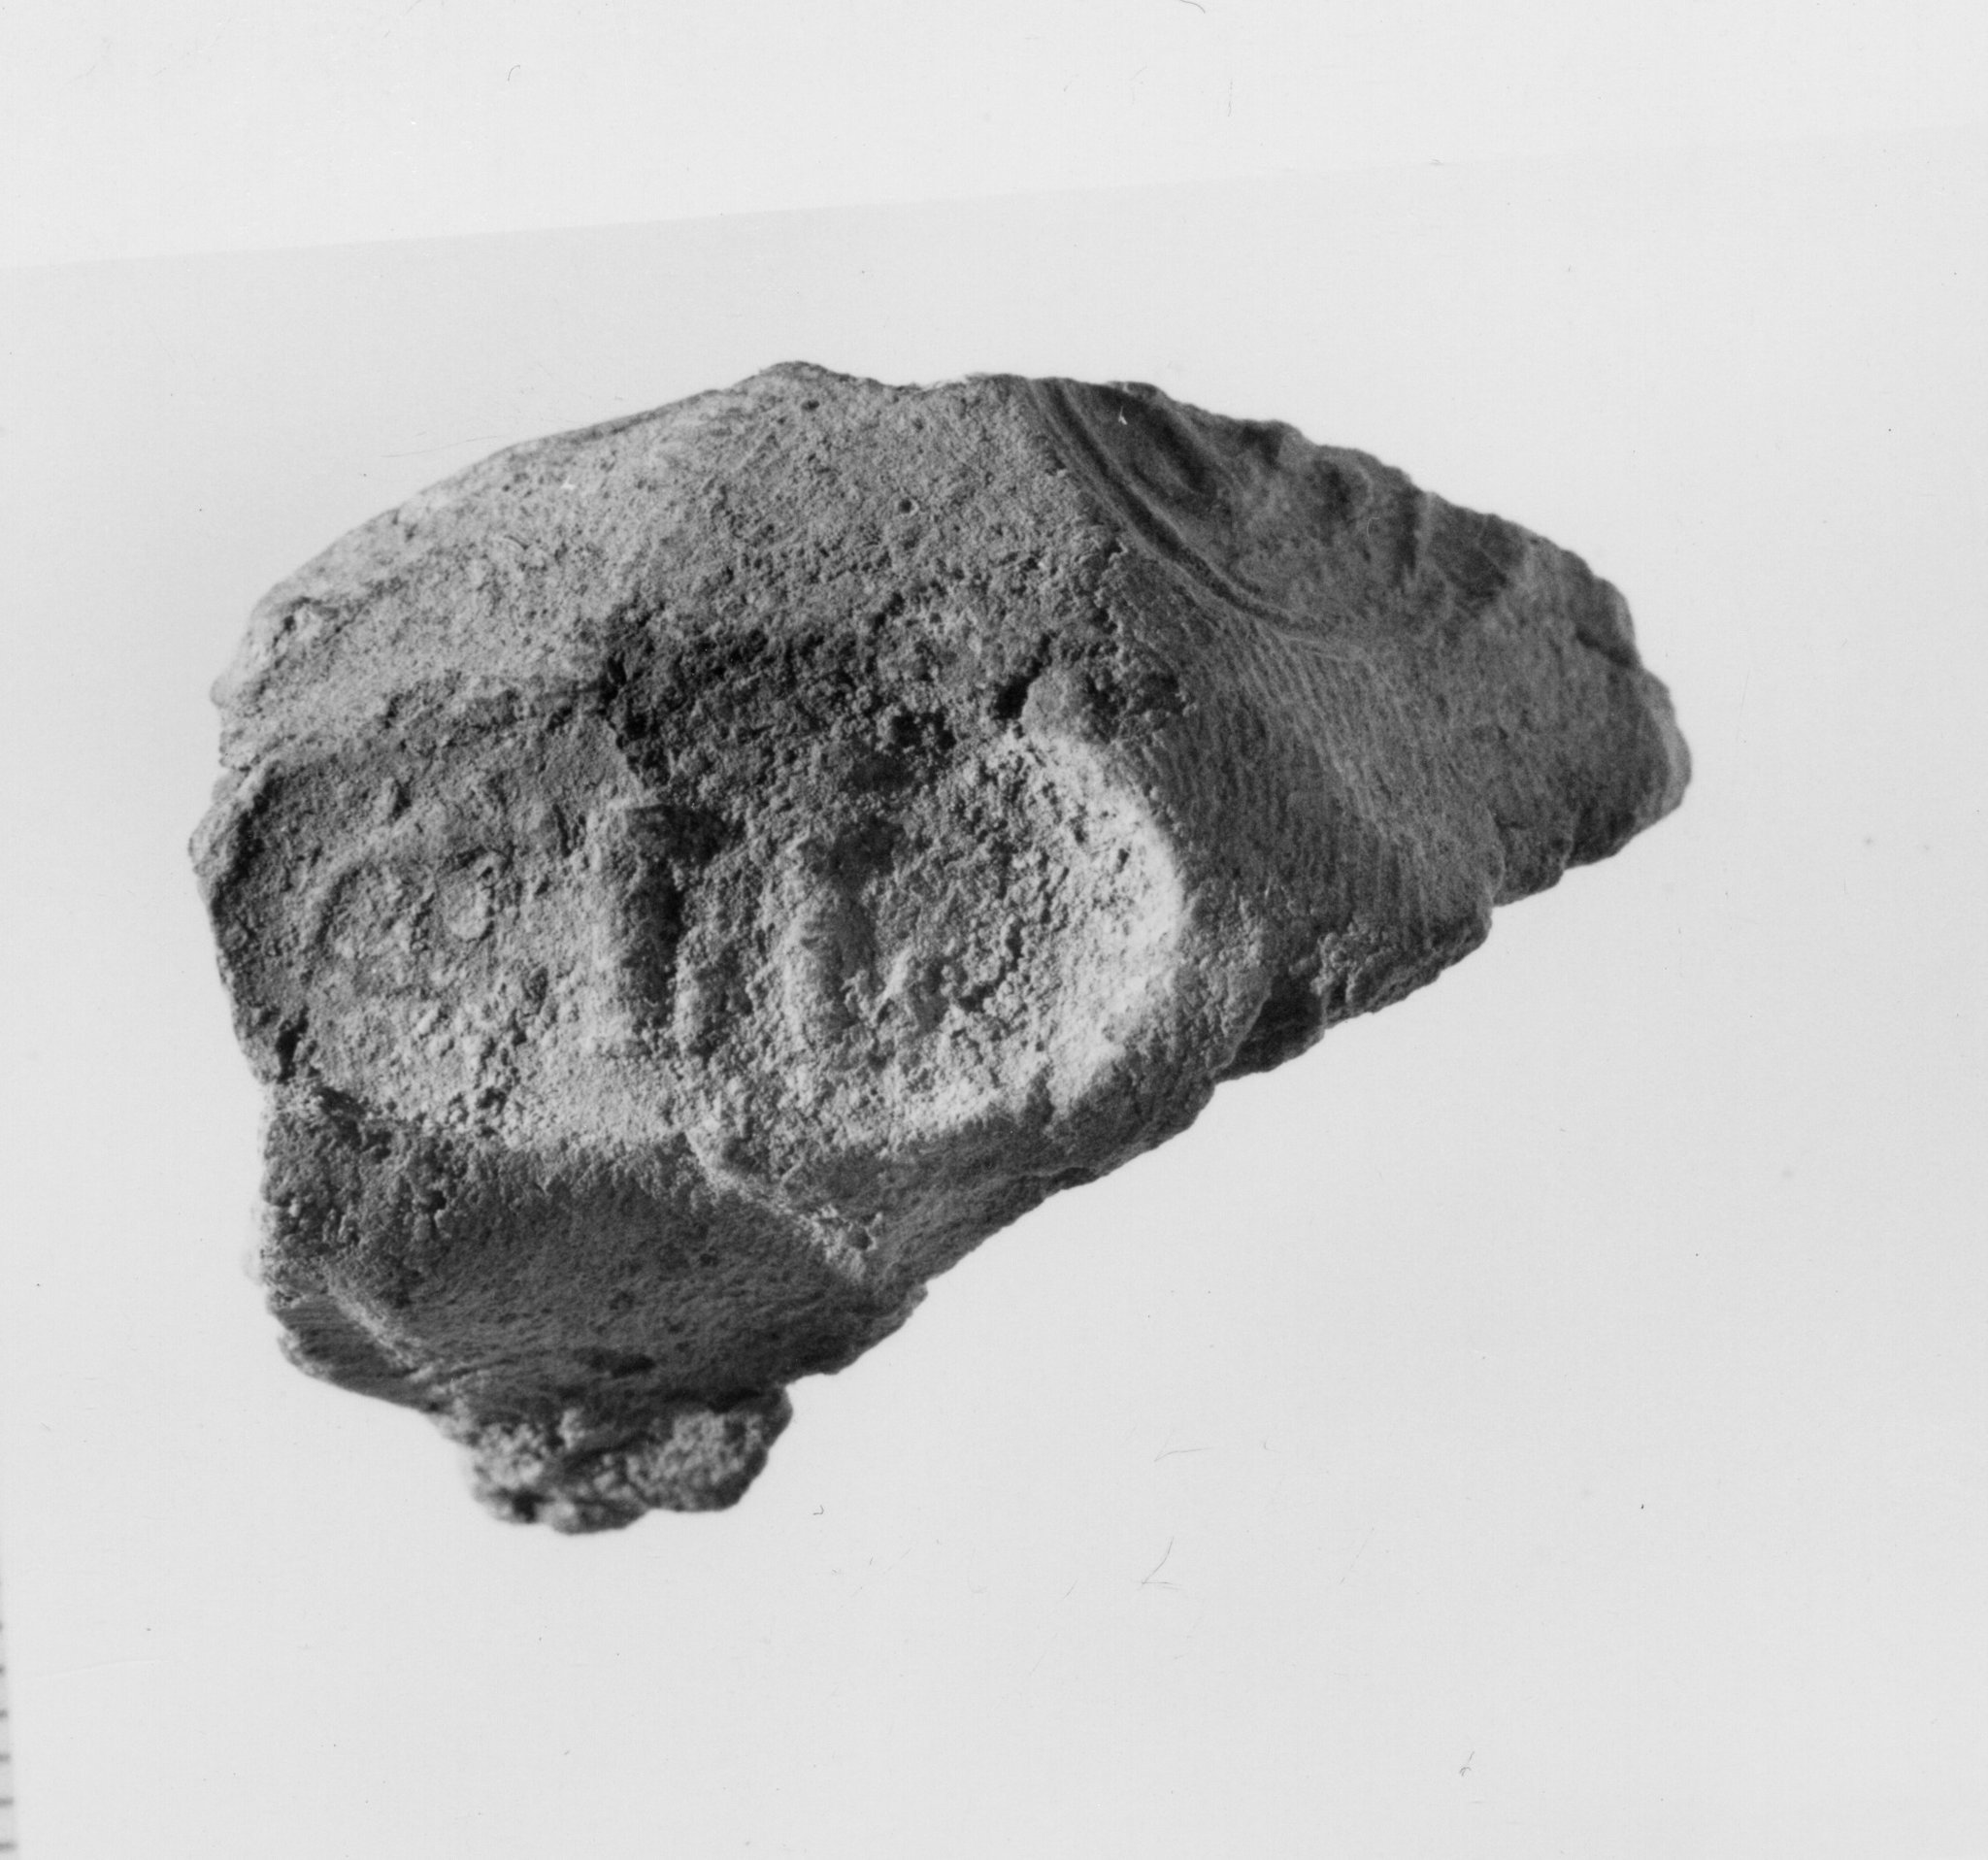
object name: sealing, amenhotep iii, nebmaatre, cobra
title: Document Sealing With Multiple Seal Impressions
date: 1390-1352 BCE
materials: mud